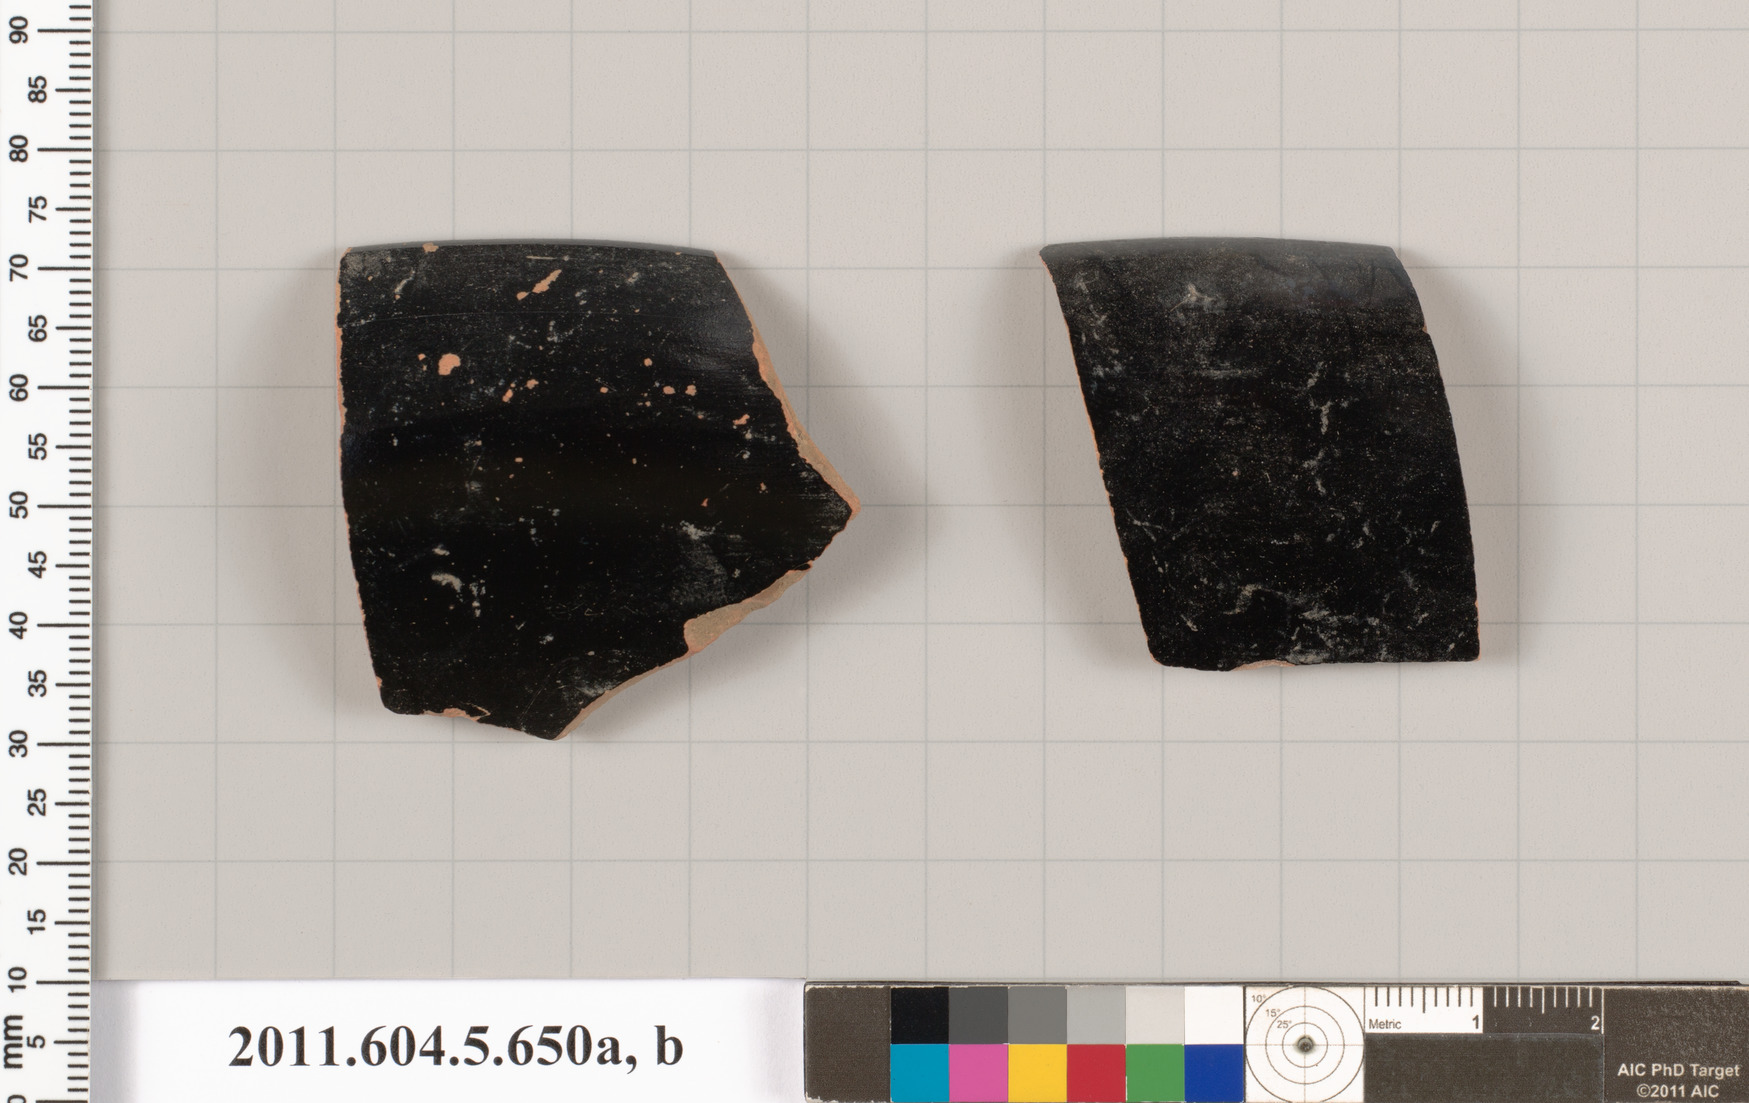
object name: kylix fragment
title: Terracotta rim fragments of kylikes (drinking cups)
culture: greek, attic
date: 600-401 BCE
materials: terracotta